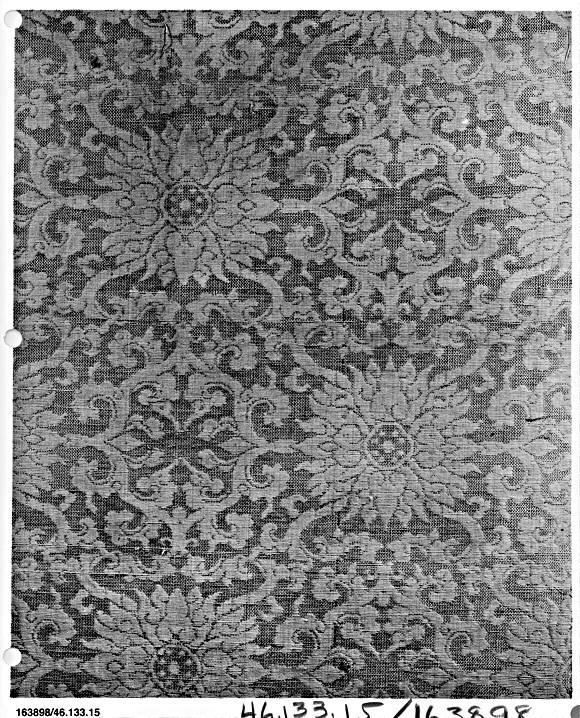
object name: piece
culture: chinese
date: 1601-1700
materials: cotton, silk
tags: flowers